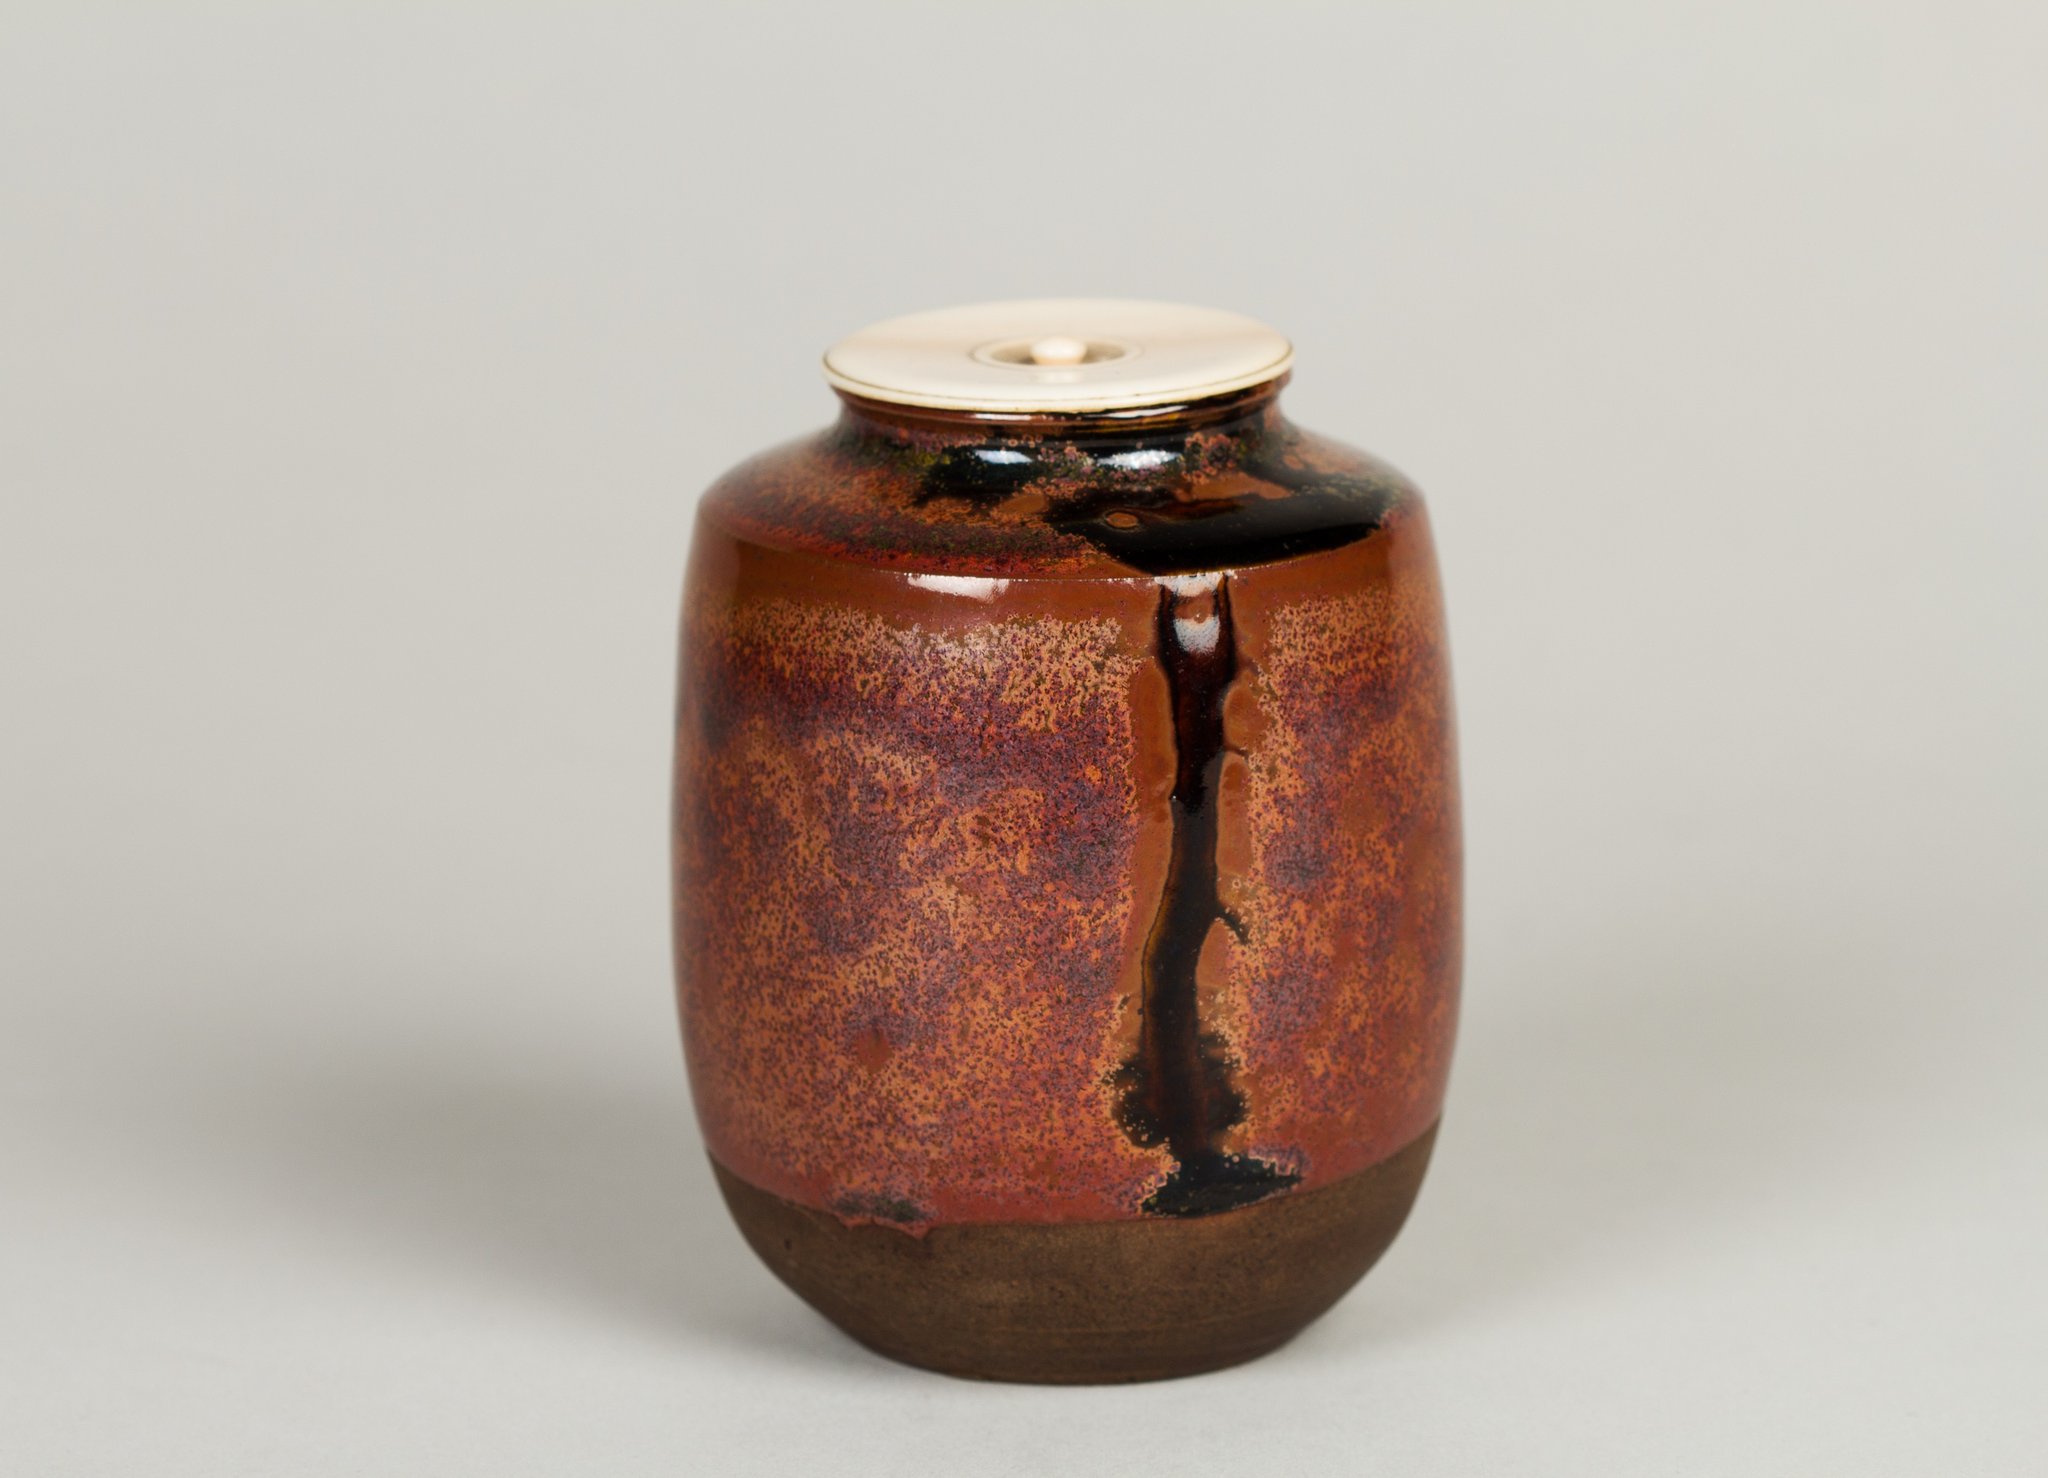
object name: tea caddy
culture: japanese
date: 1701-1800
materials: glaze, stoneware